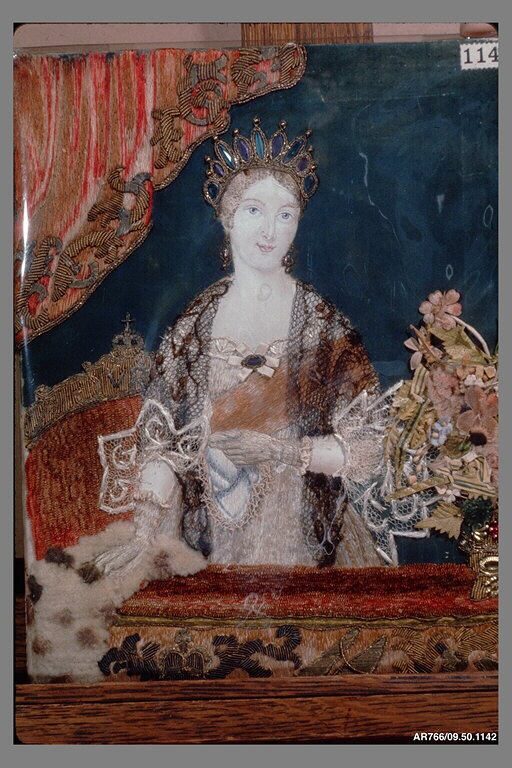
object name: panel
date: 1801-1900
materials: silk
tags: portraits,women